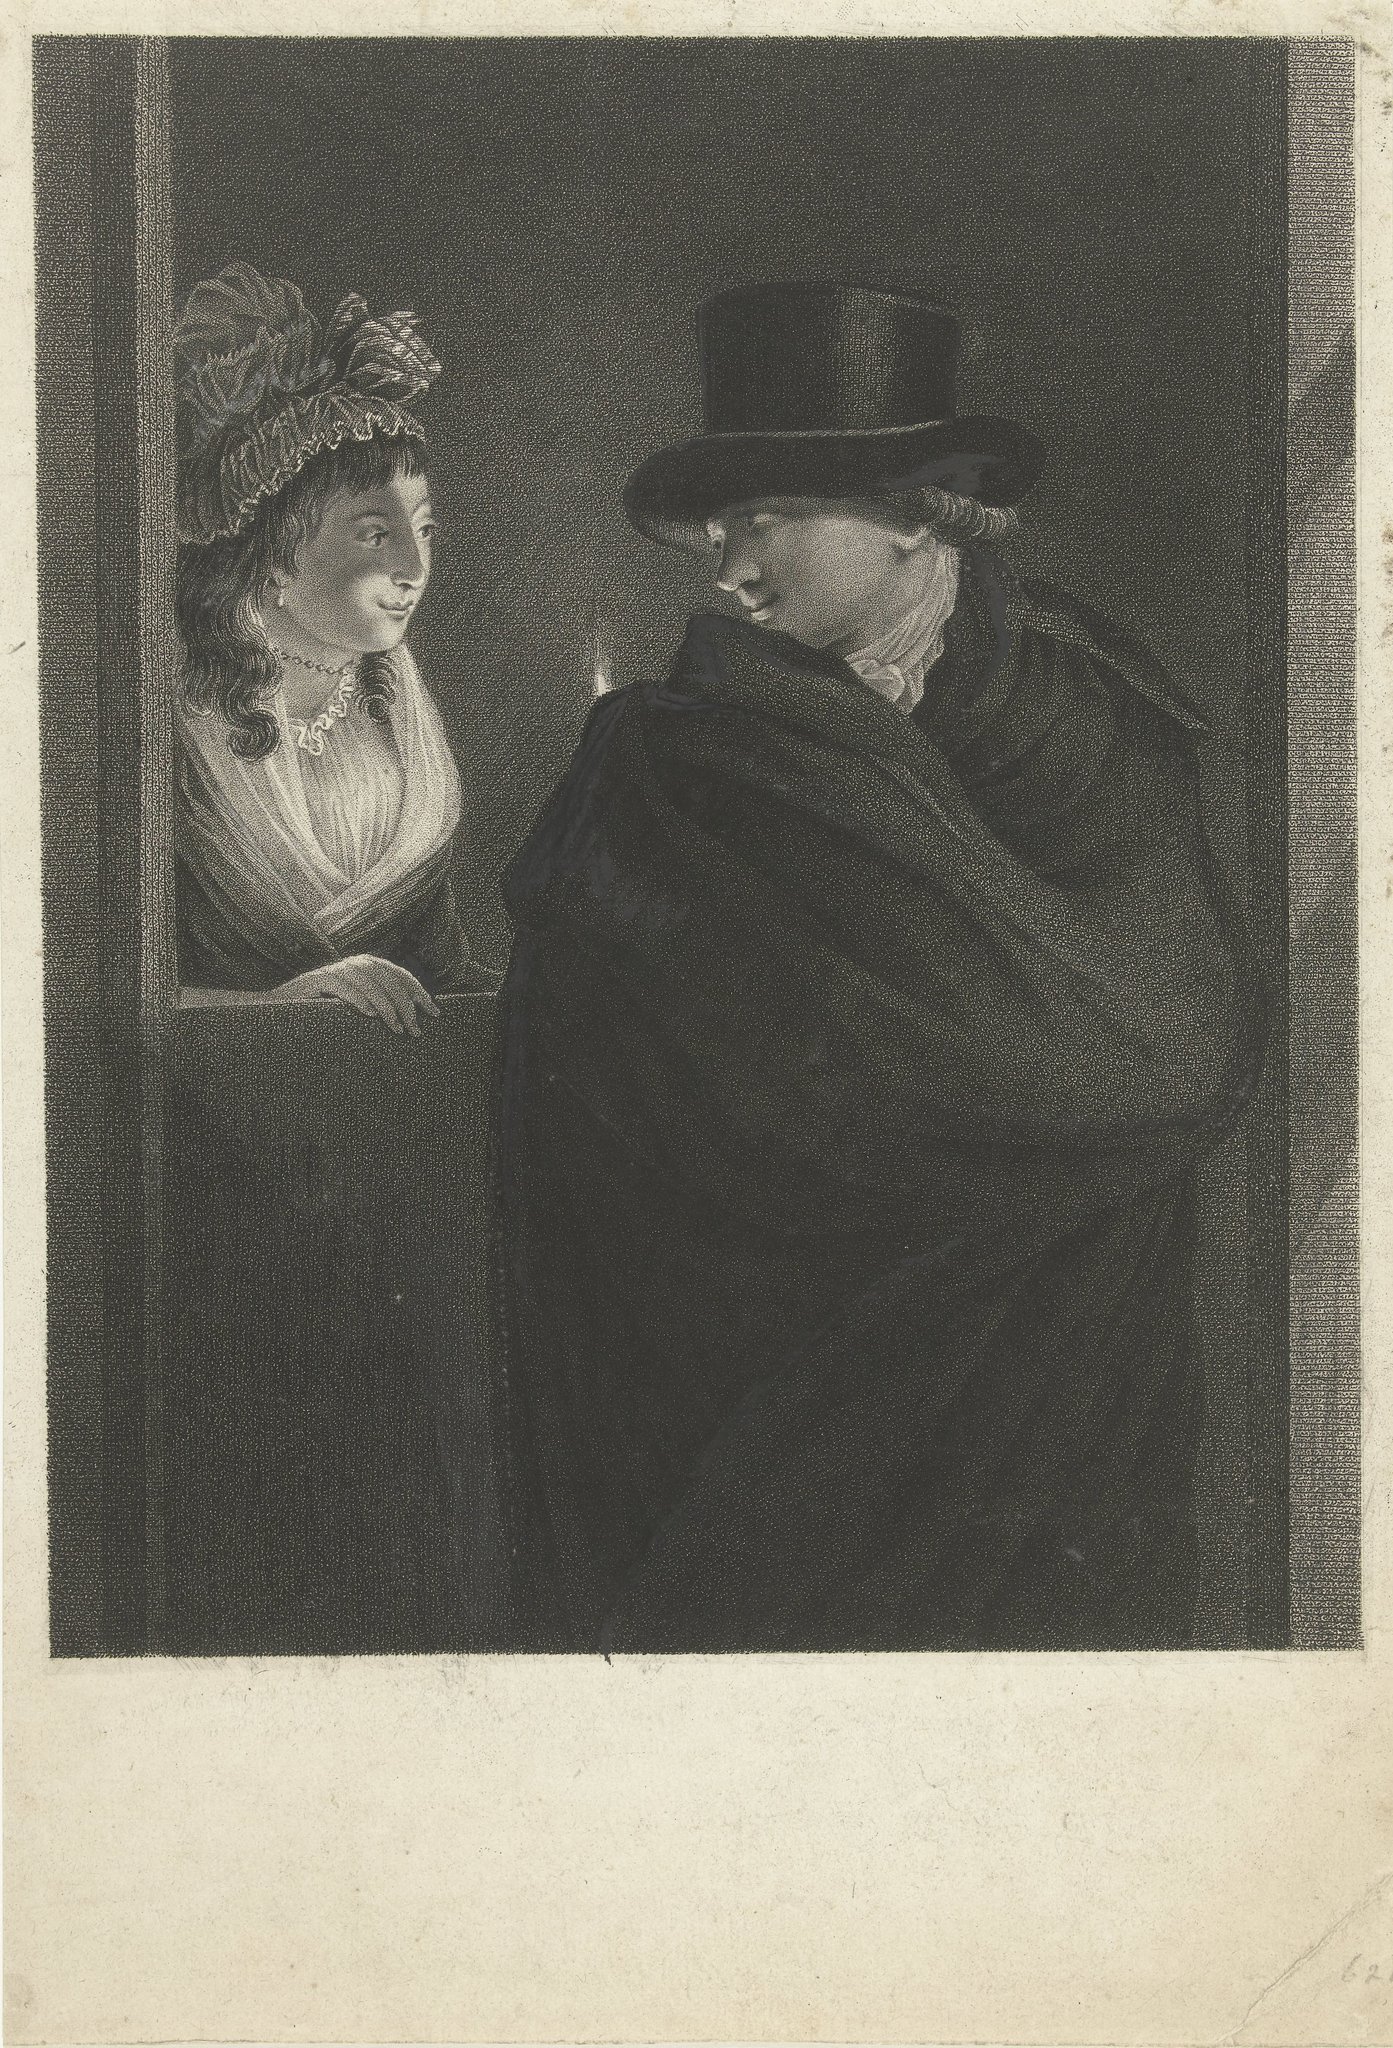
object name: print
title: Amante inconstante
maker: lambertus antonius claessens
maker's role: draughtsman, print maker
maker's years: 1763-1834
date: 1792-1817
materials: paper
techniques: brush, etching, engraving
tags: parting, leave-taking (of lovers)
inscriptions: collector's mark: Lugt 2228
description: Een heer met hoed en mantel neemt aan de deur afscheid van een jonge vrouw. De vrouw staat met een brandende kaars in haar hand en sluit met haar andere hand de onderdeur van het huis terwijl ze haar geliefde in de ogen kijkt. Deze prent vormt een pendant met een voorstelling van de wachtende vrouw bij de deur.